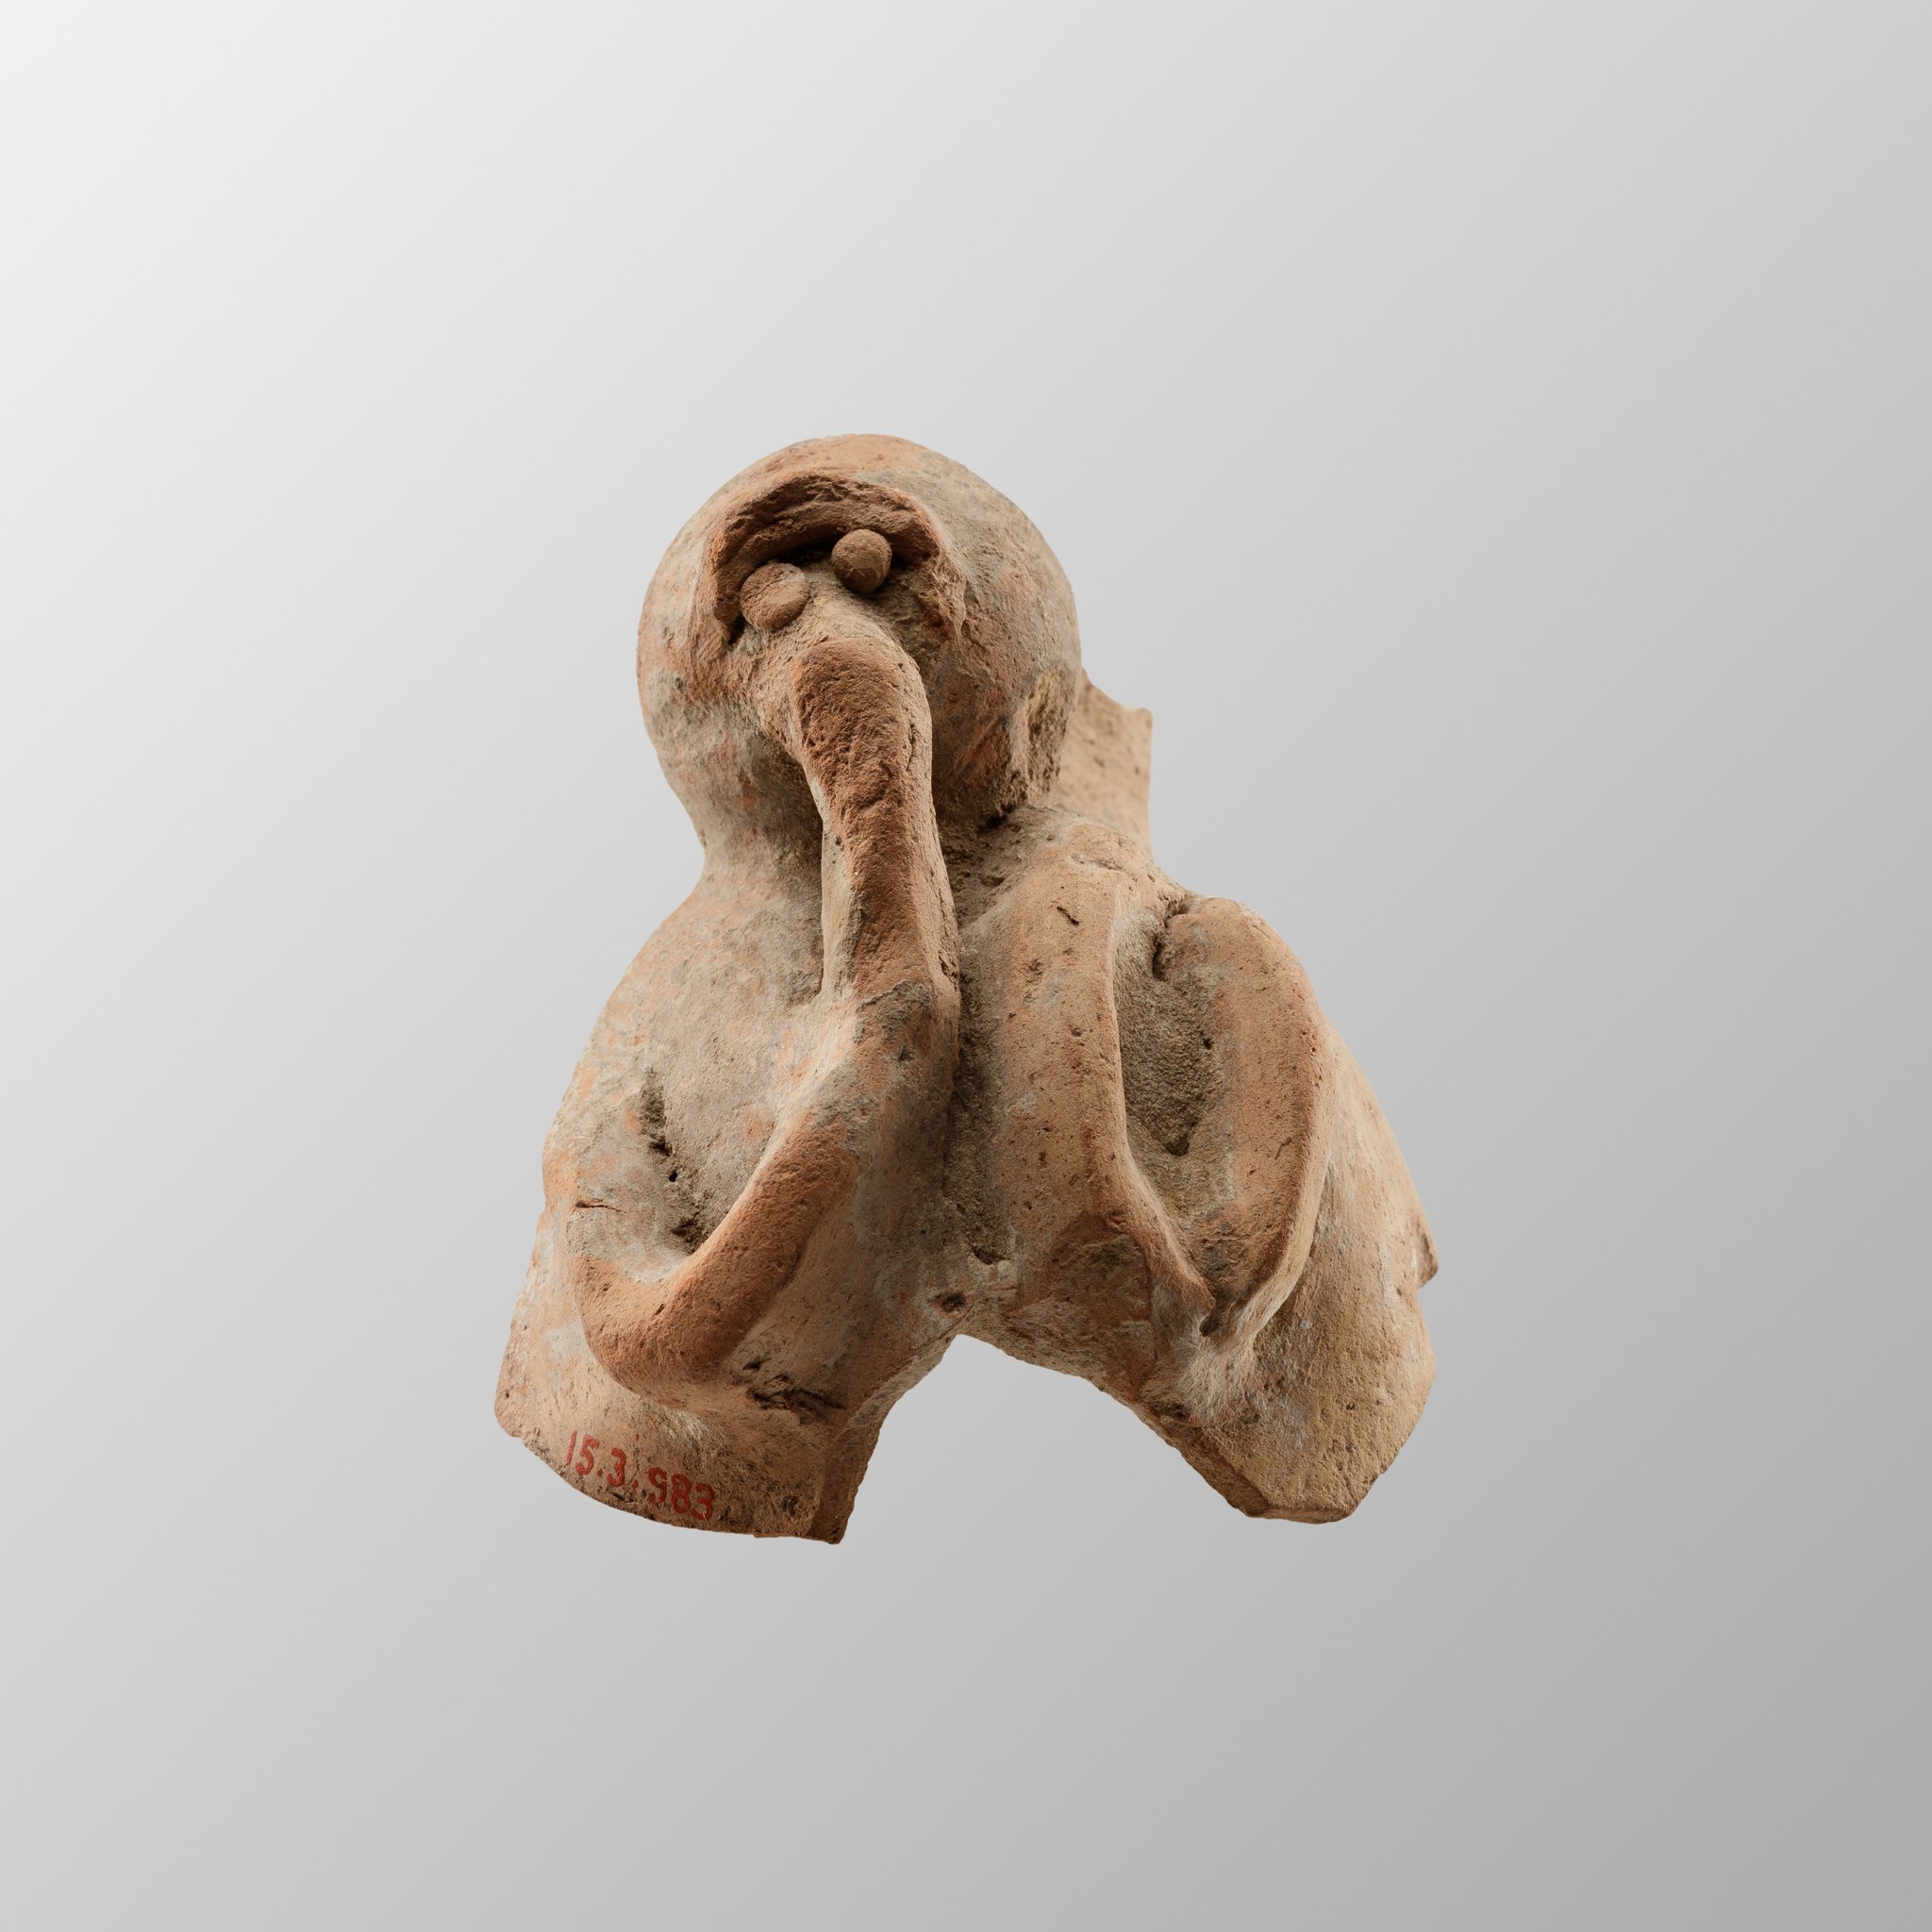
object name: vase, monkey, baby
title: Vase fragment in the shape of a monkey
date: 1295-1070 BCE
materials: pottery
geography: egypt